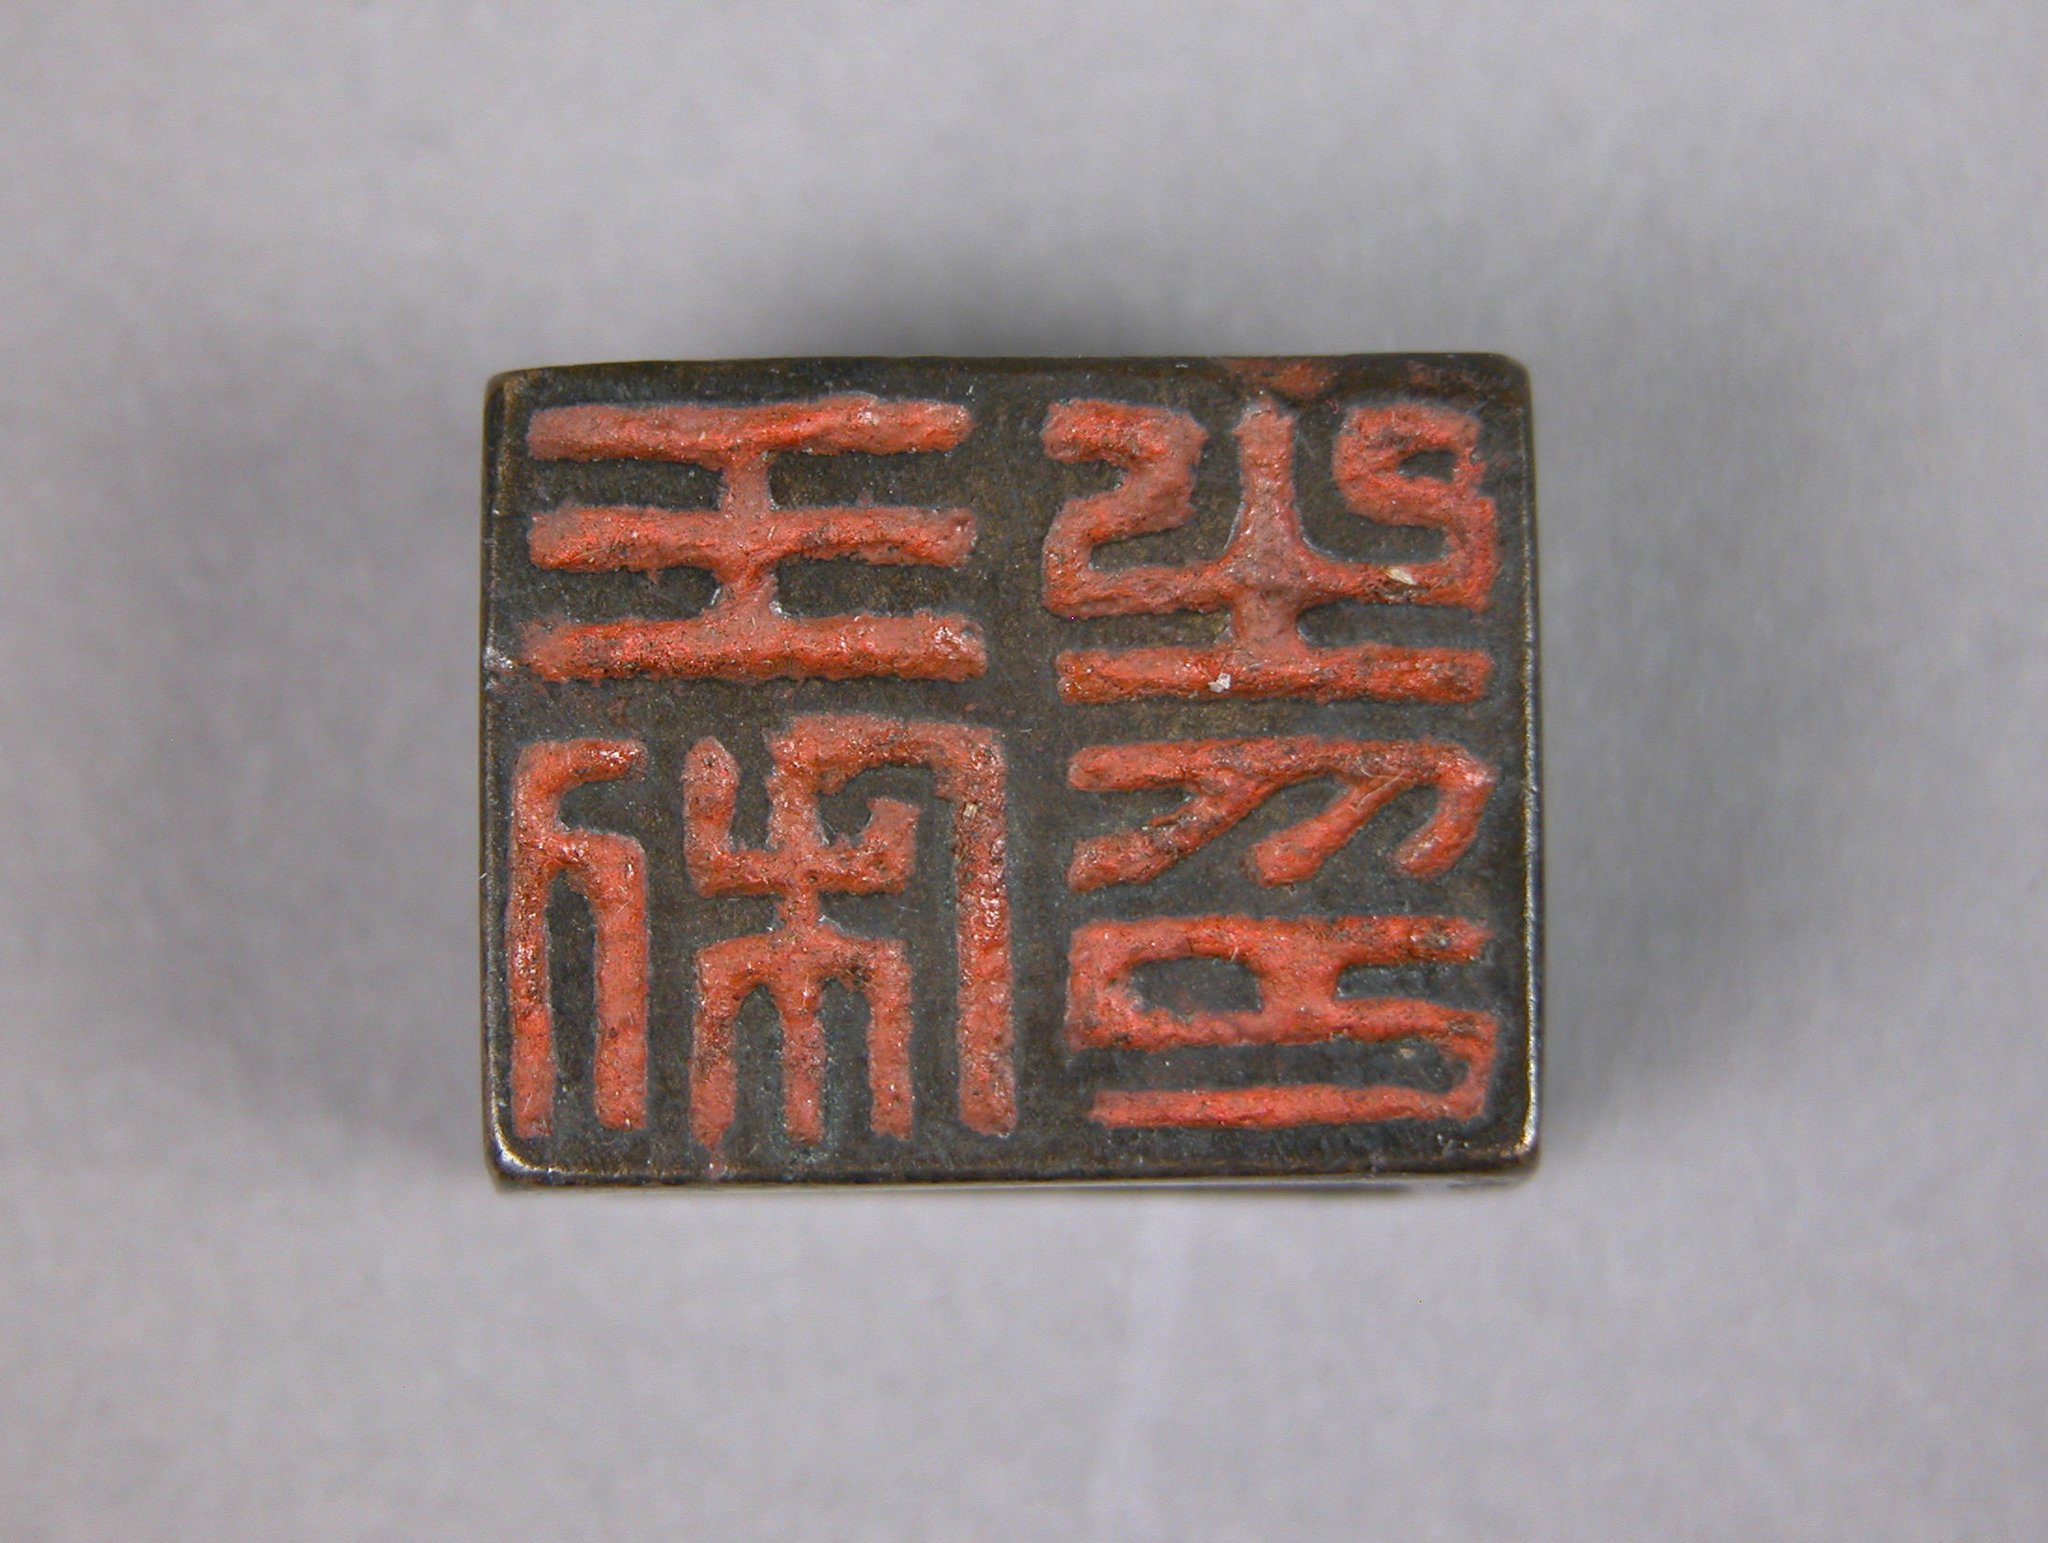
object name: seal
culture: chinese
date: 1300-1644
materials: bronze